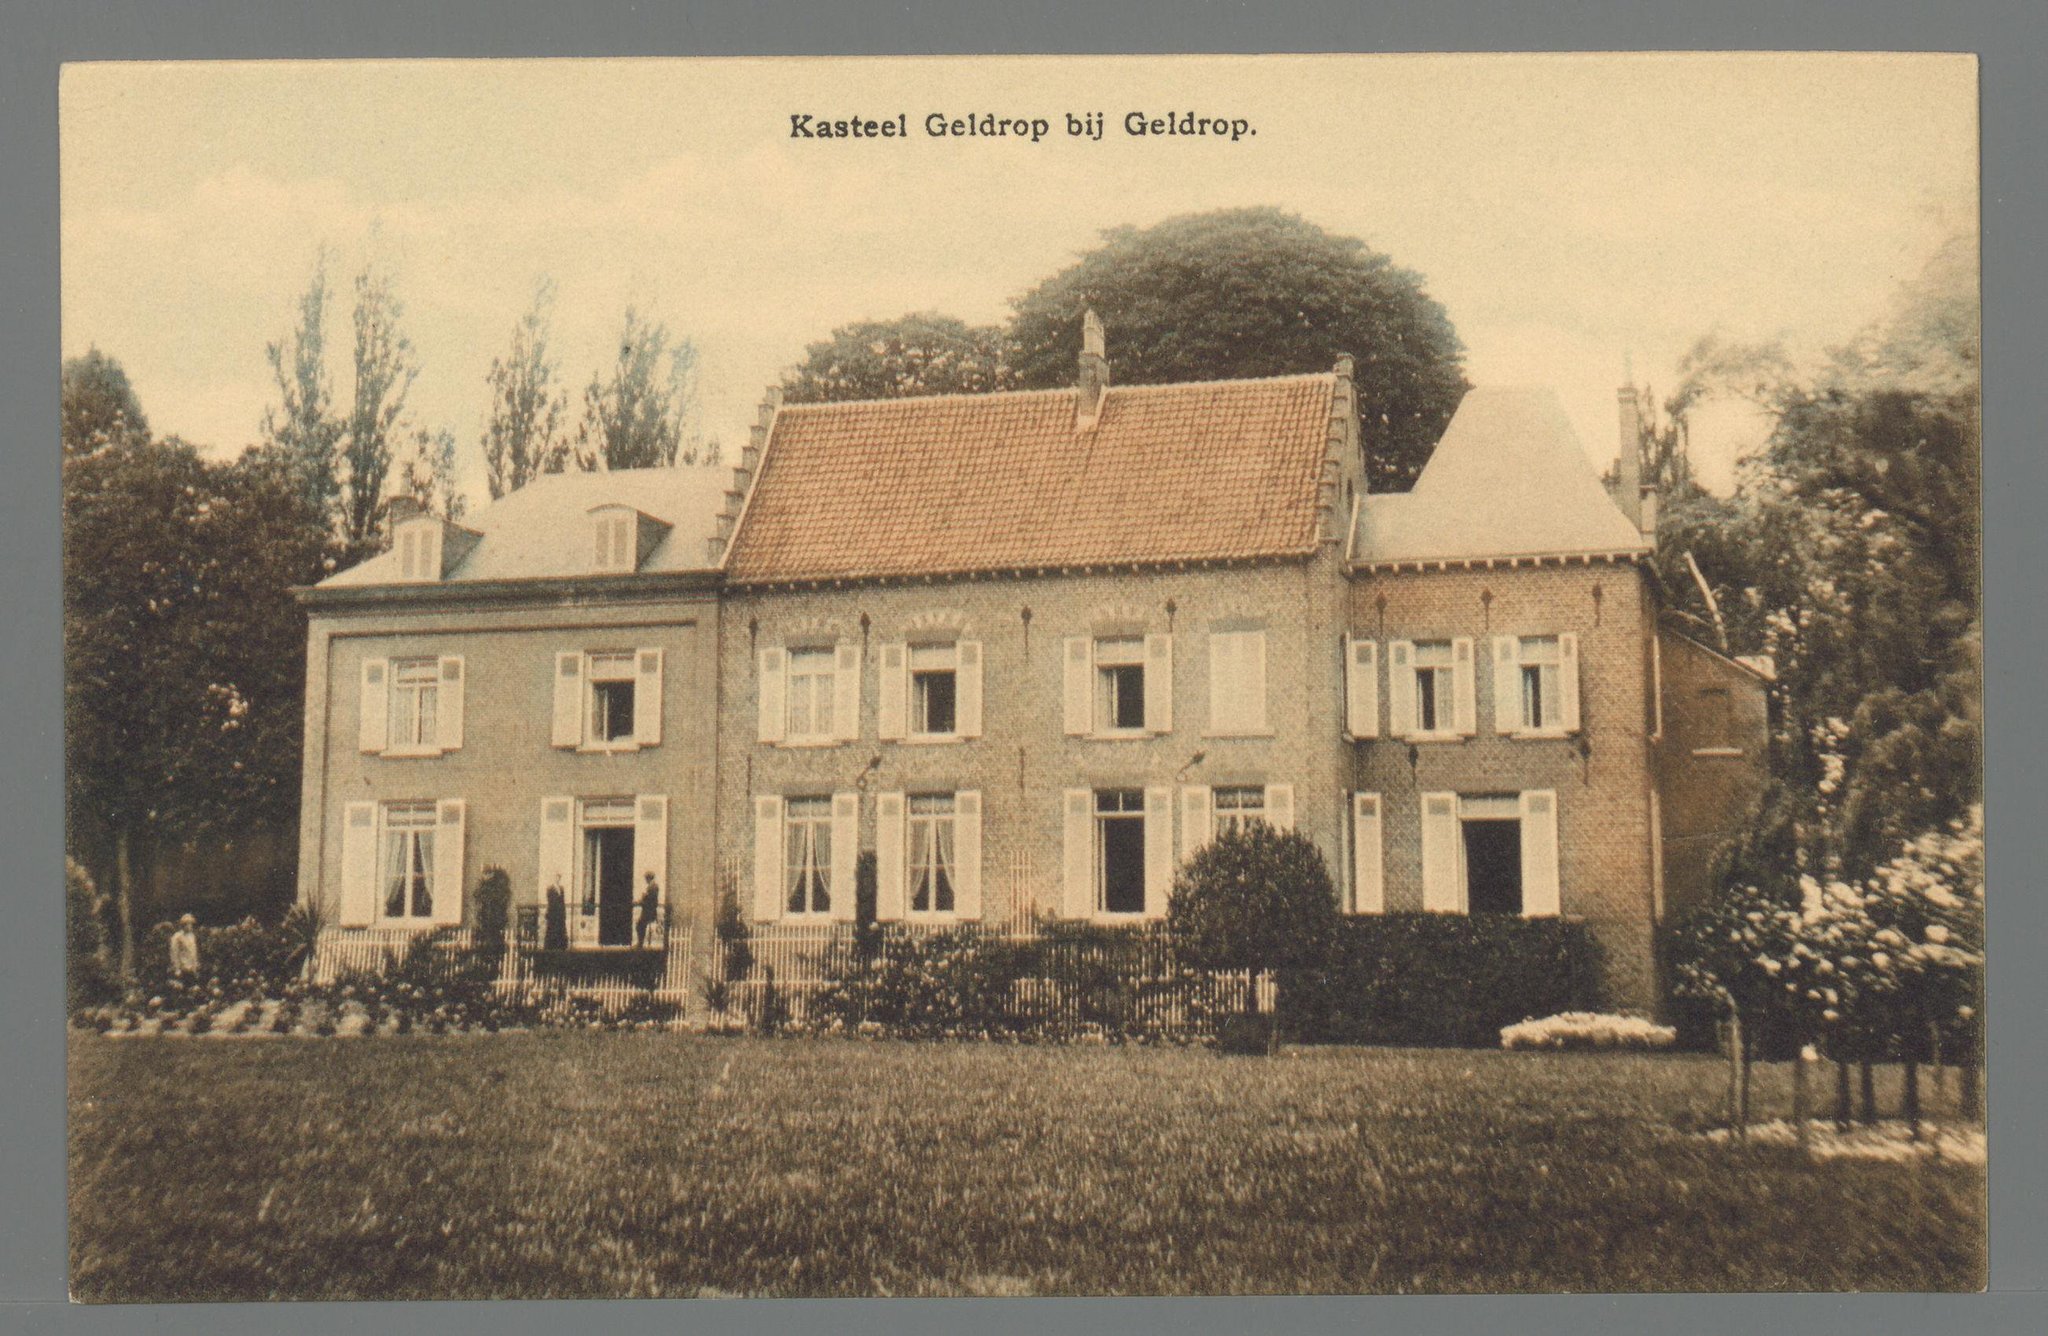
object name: photomechanical print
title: Kasteel Geldrop bij Geldrop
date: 1905-1930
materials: cardboard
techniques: collotype process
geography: amsterdam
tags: castle